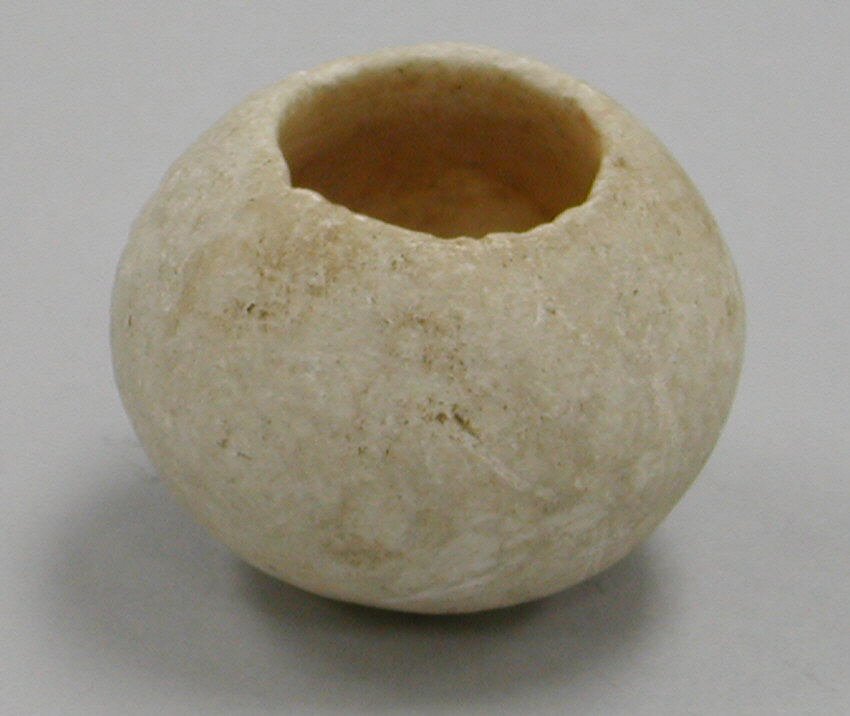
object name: bowl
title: Onyx Bowl (Tecomate)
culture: mexican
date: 1501-1600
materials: marble, onyx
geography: mexico